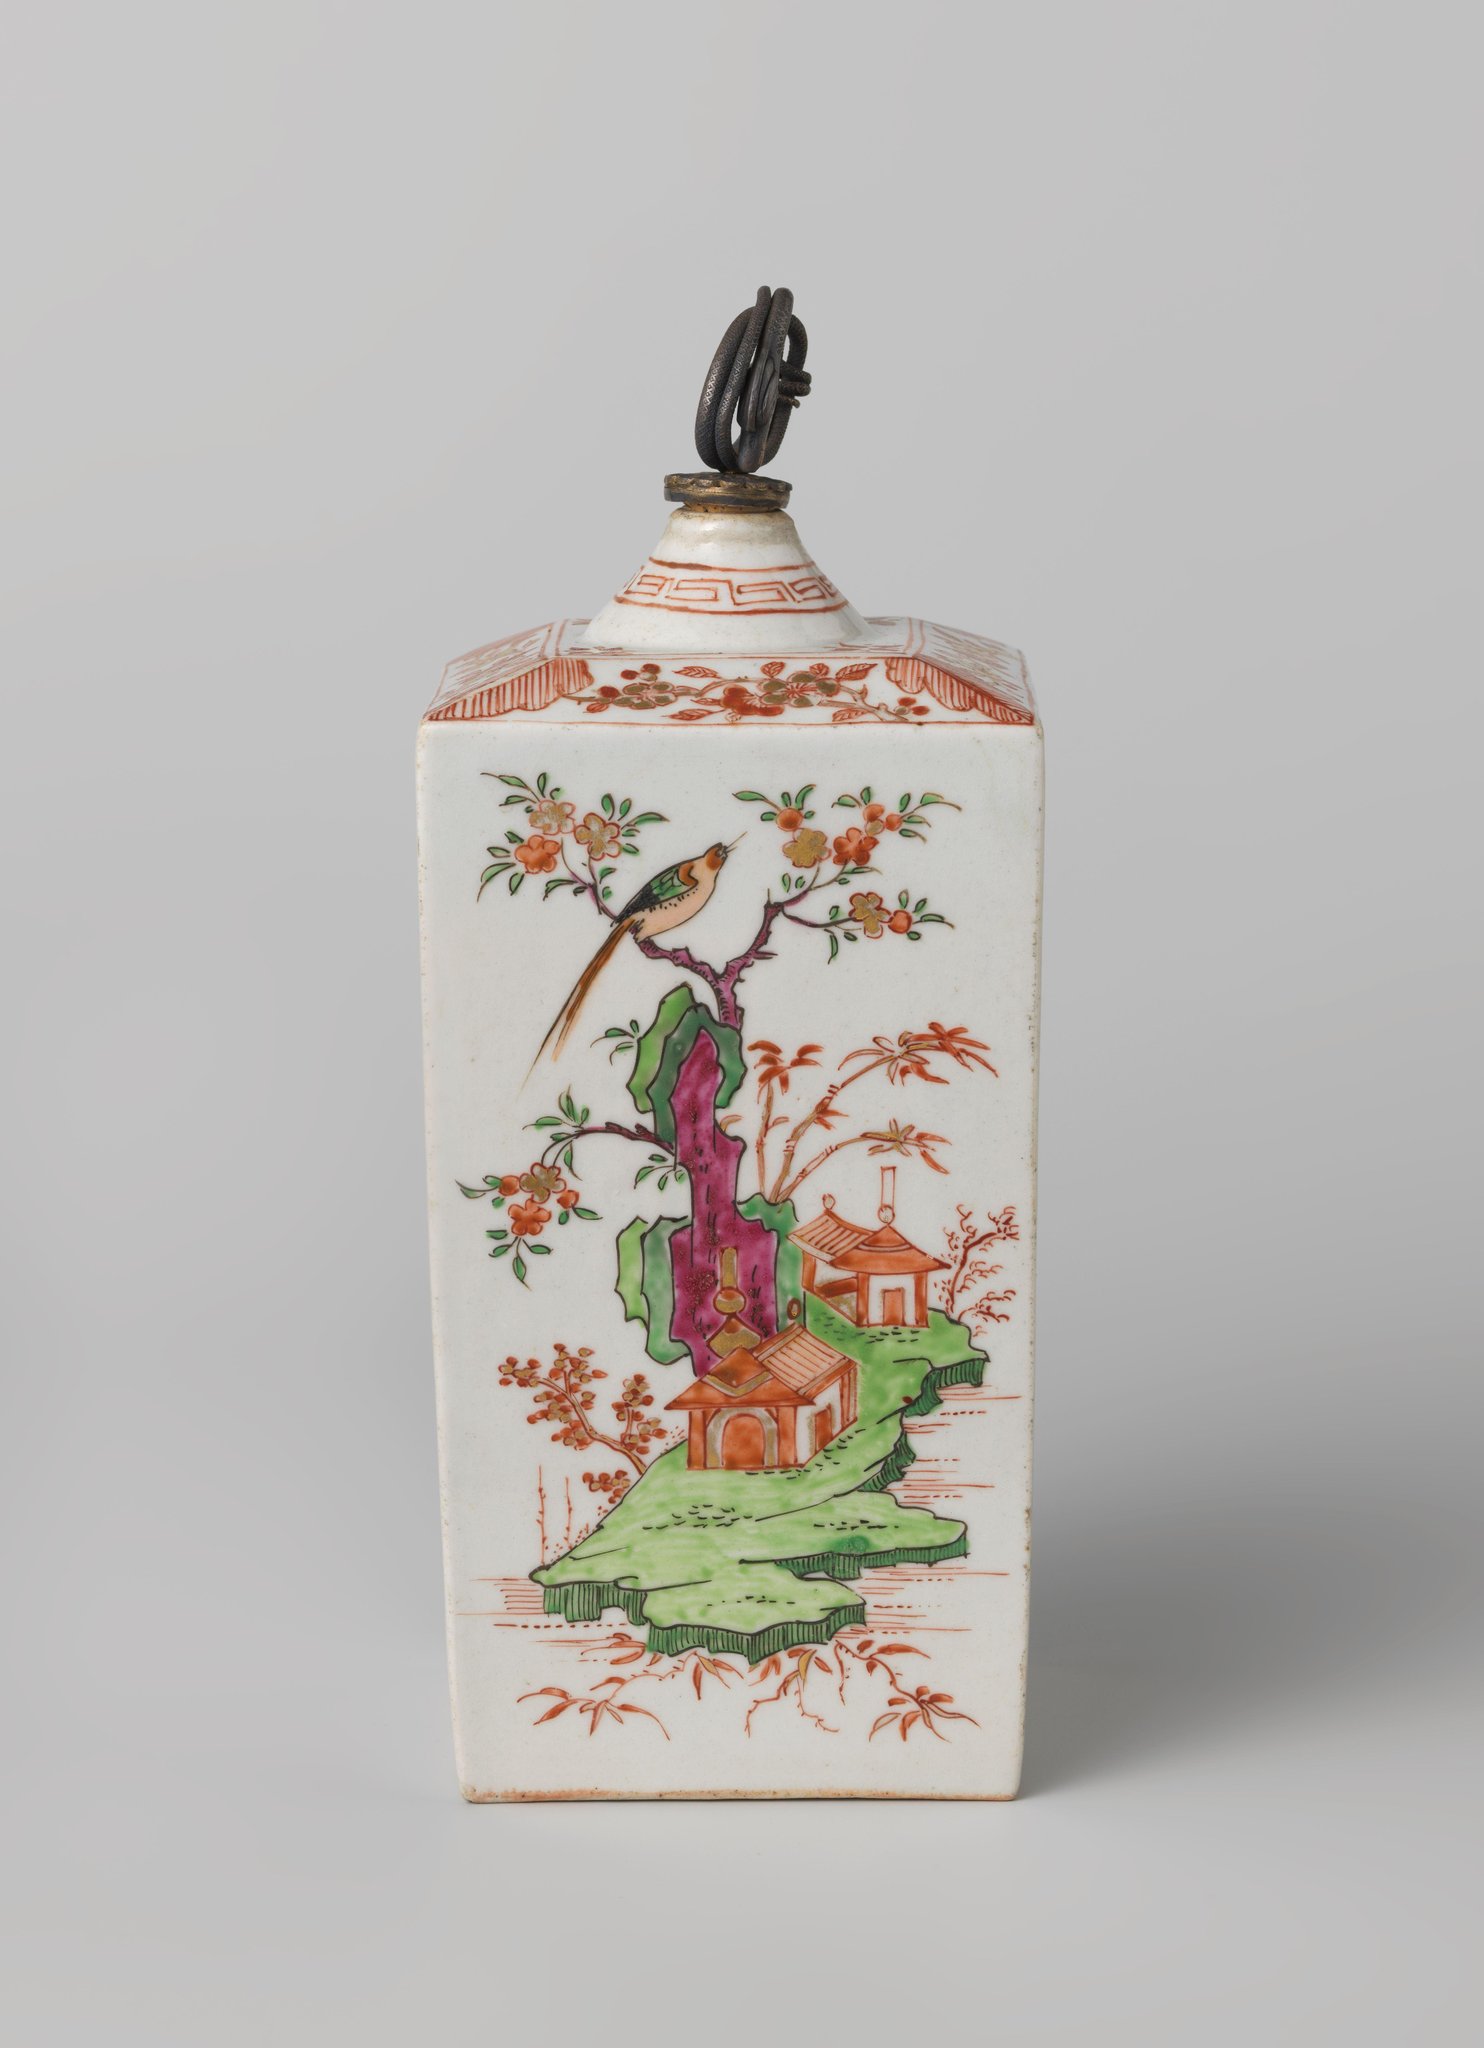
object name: bottle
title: Square bottle with birds, flowering plants and pavilions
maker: Anonymous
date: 1700-1724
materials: bronze, glaze, gold, paint, porcelain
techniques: firing, forming, gilding, vitrification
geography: arita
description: Vierkante fles van porselein met een verguld, bronzen dop, beschilderd op het glazuur in rood, groen, geel, paars, zwart en goud. Op de wanden tweemaal paviljoens op een eiland met rotsen en bloeiende planten (bamboe), een vogel op een tak, en tweemaal een vliegende vogel bij een prunustak en bamboe. Op de schouder een band met prunustakken en een bladmotief; rond de hals ranken. Op de hals een meanderpatroon. De dop is in de vorm van een gevlochten ring, eindigend in een hoo-vogelkop op een bloemrozet. De rand is afgeslepen. Arita, in Europa gedecoreerd[?] in de Japanse Kakiemon-stijl.